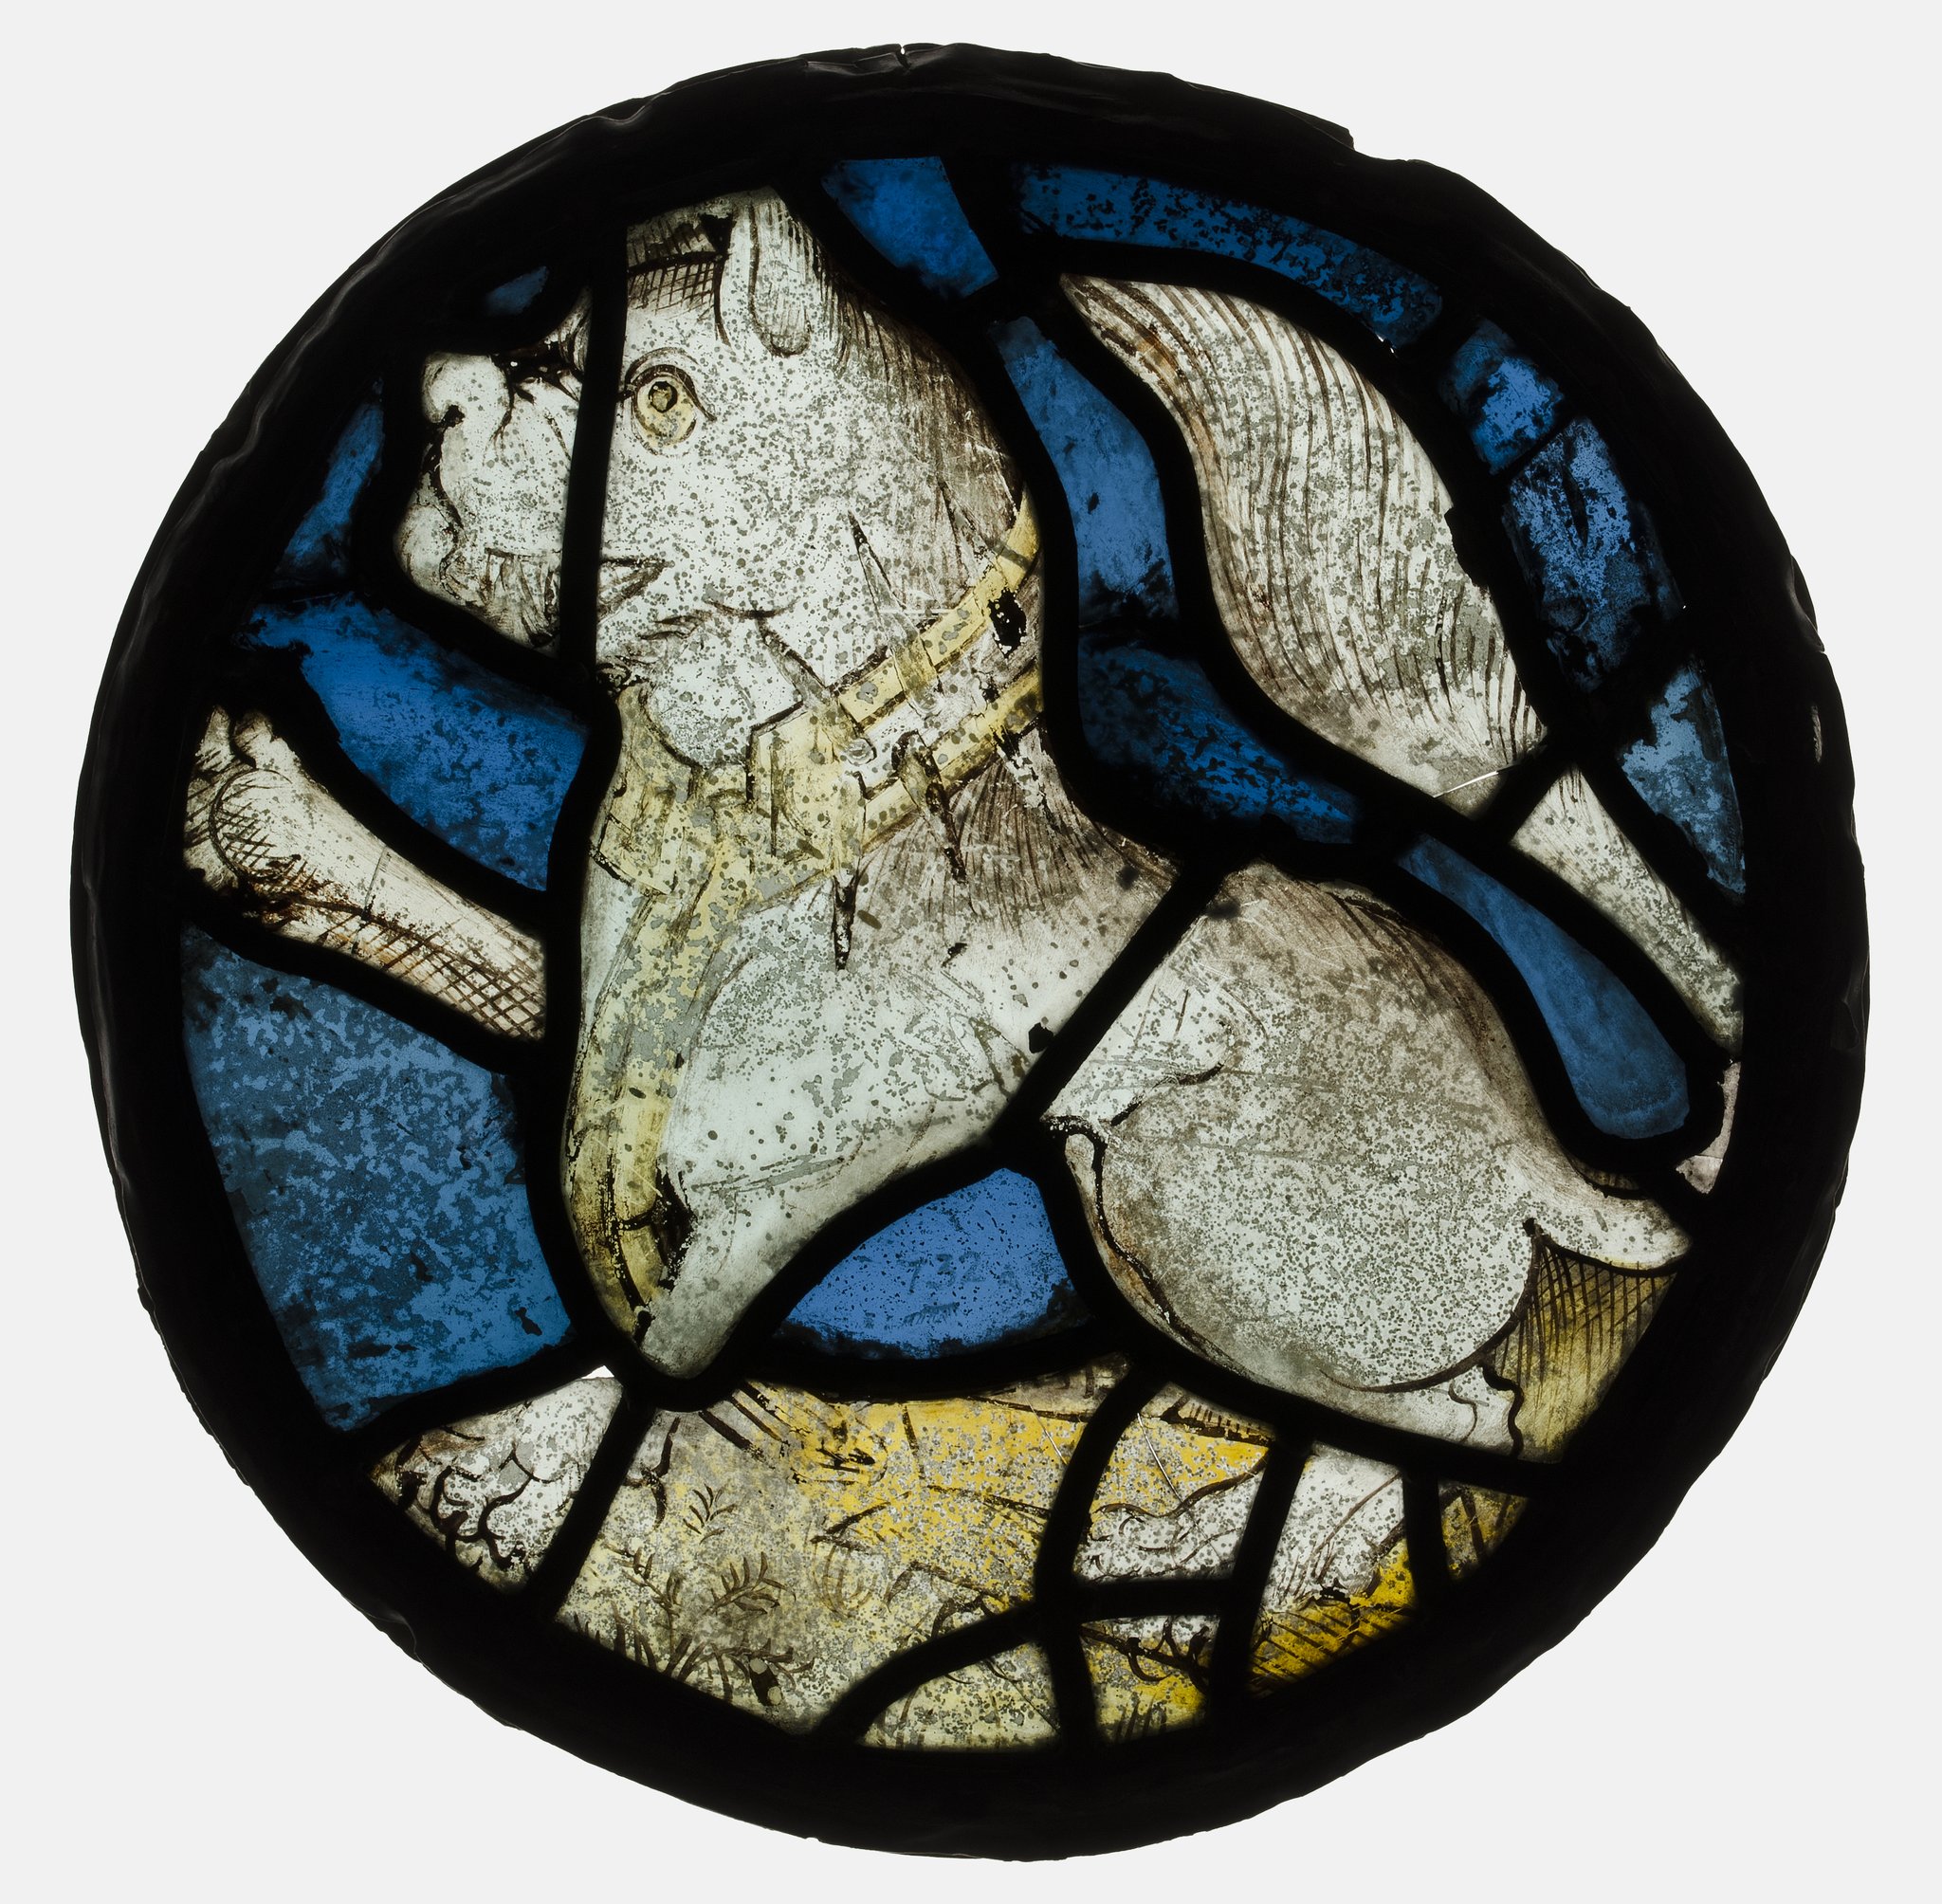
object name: roundel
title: Badge of the Fiennes Family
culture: british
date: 1450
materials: glass, metal, paint